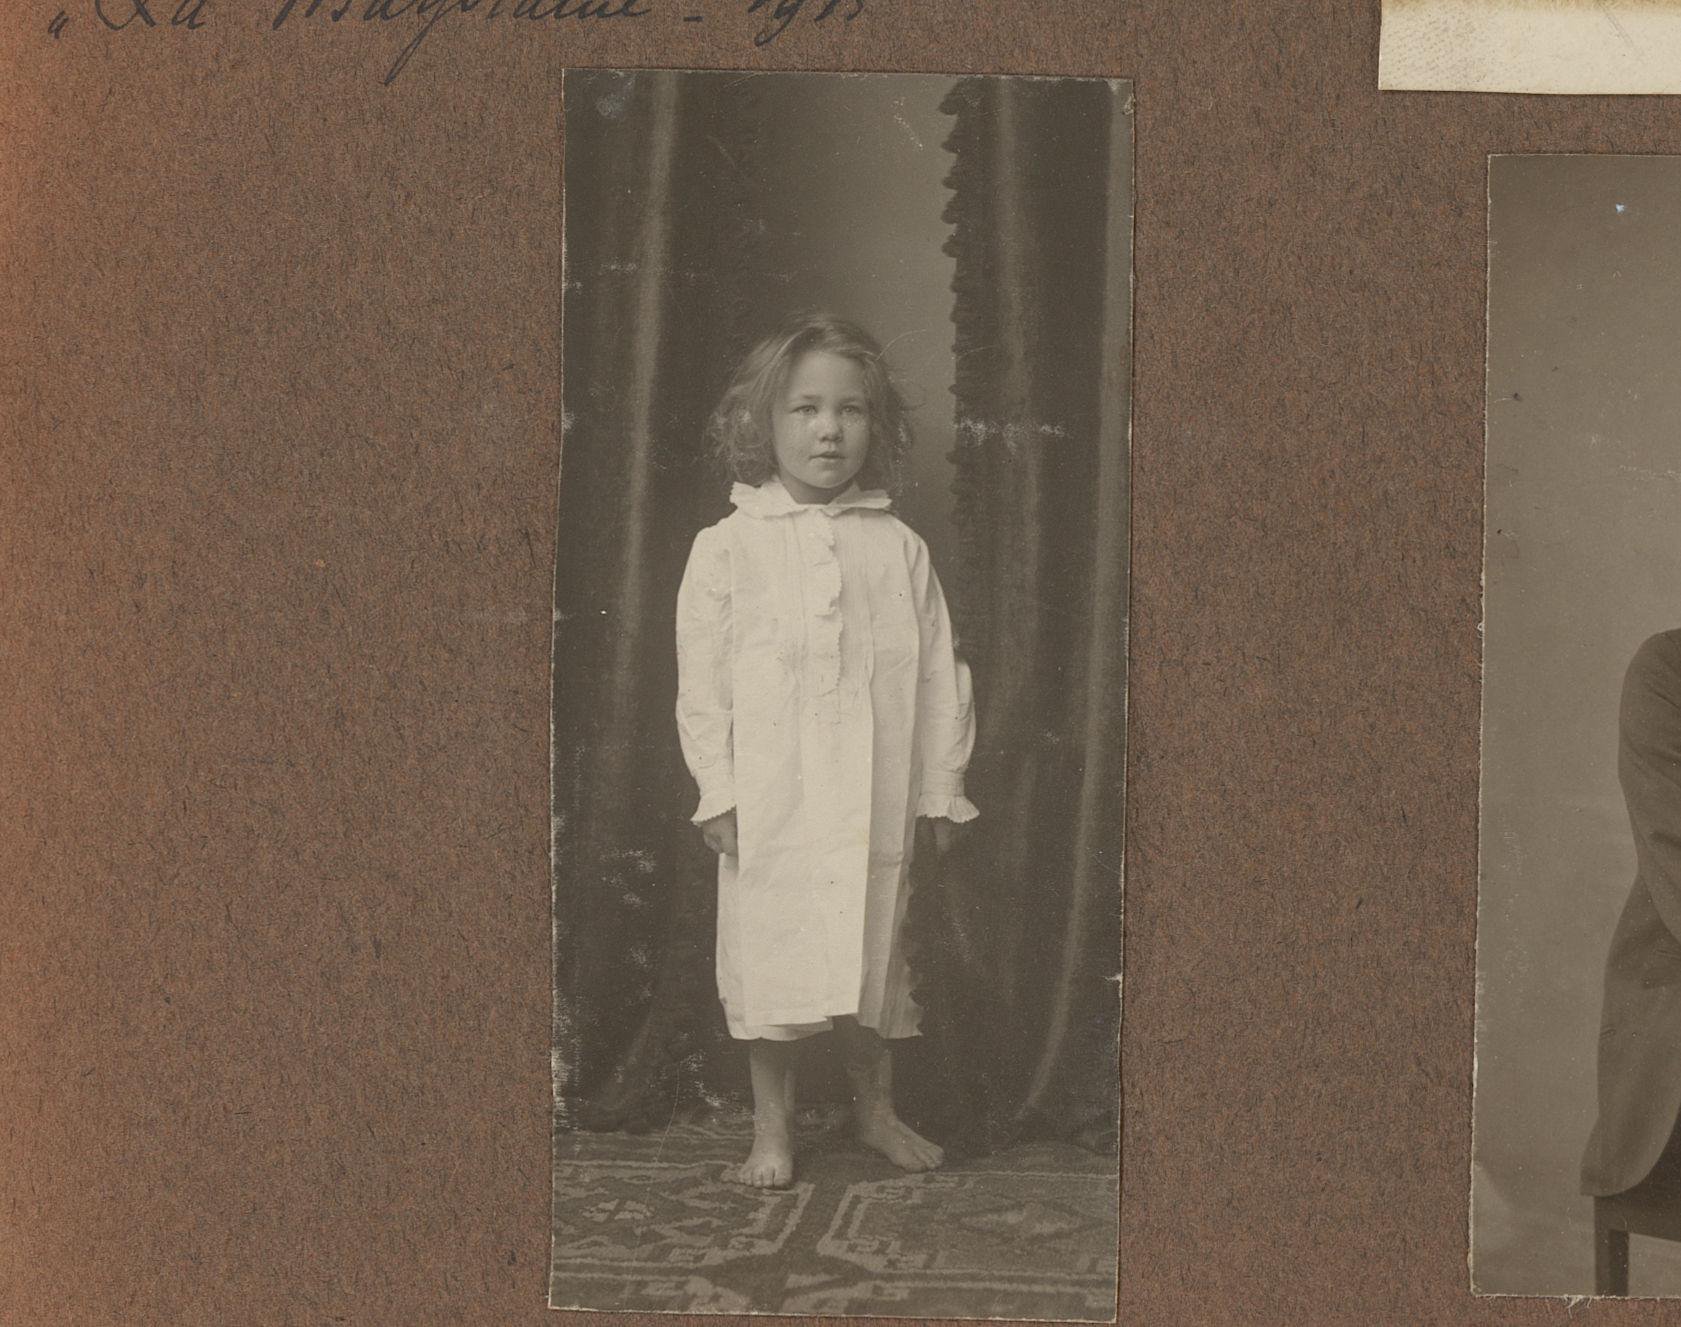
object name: photograph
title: Staand meisje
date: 1911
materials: photographic support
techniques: photography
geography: amsterdam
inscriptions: date: ‘1911’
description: Foto op bruin albumblad 24 van familiealbum van Alphons Diepenbrock.